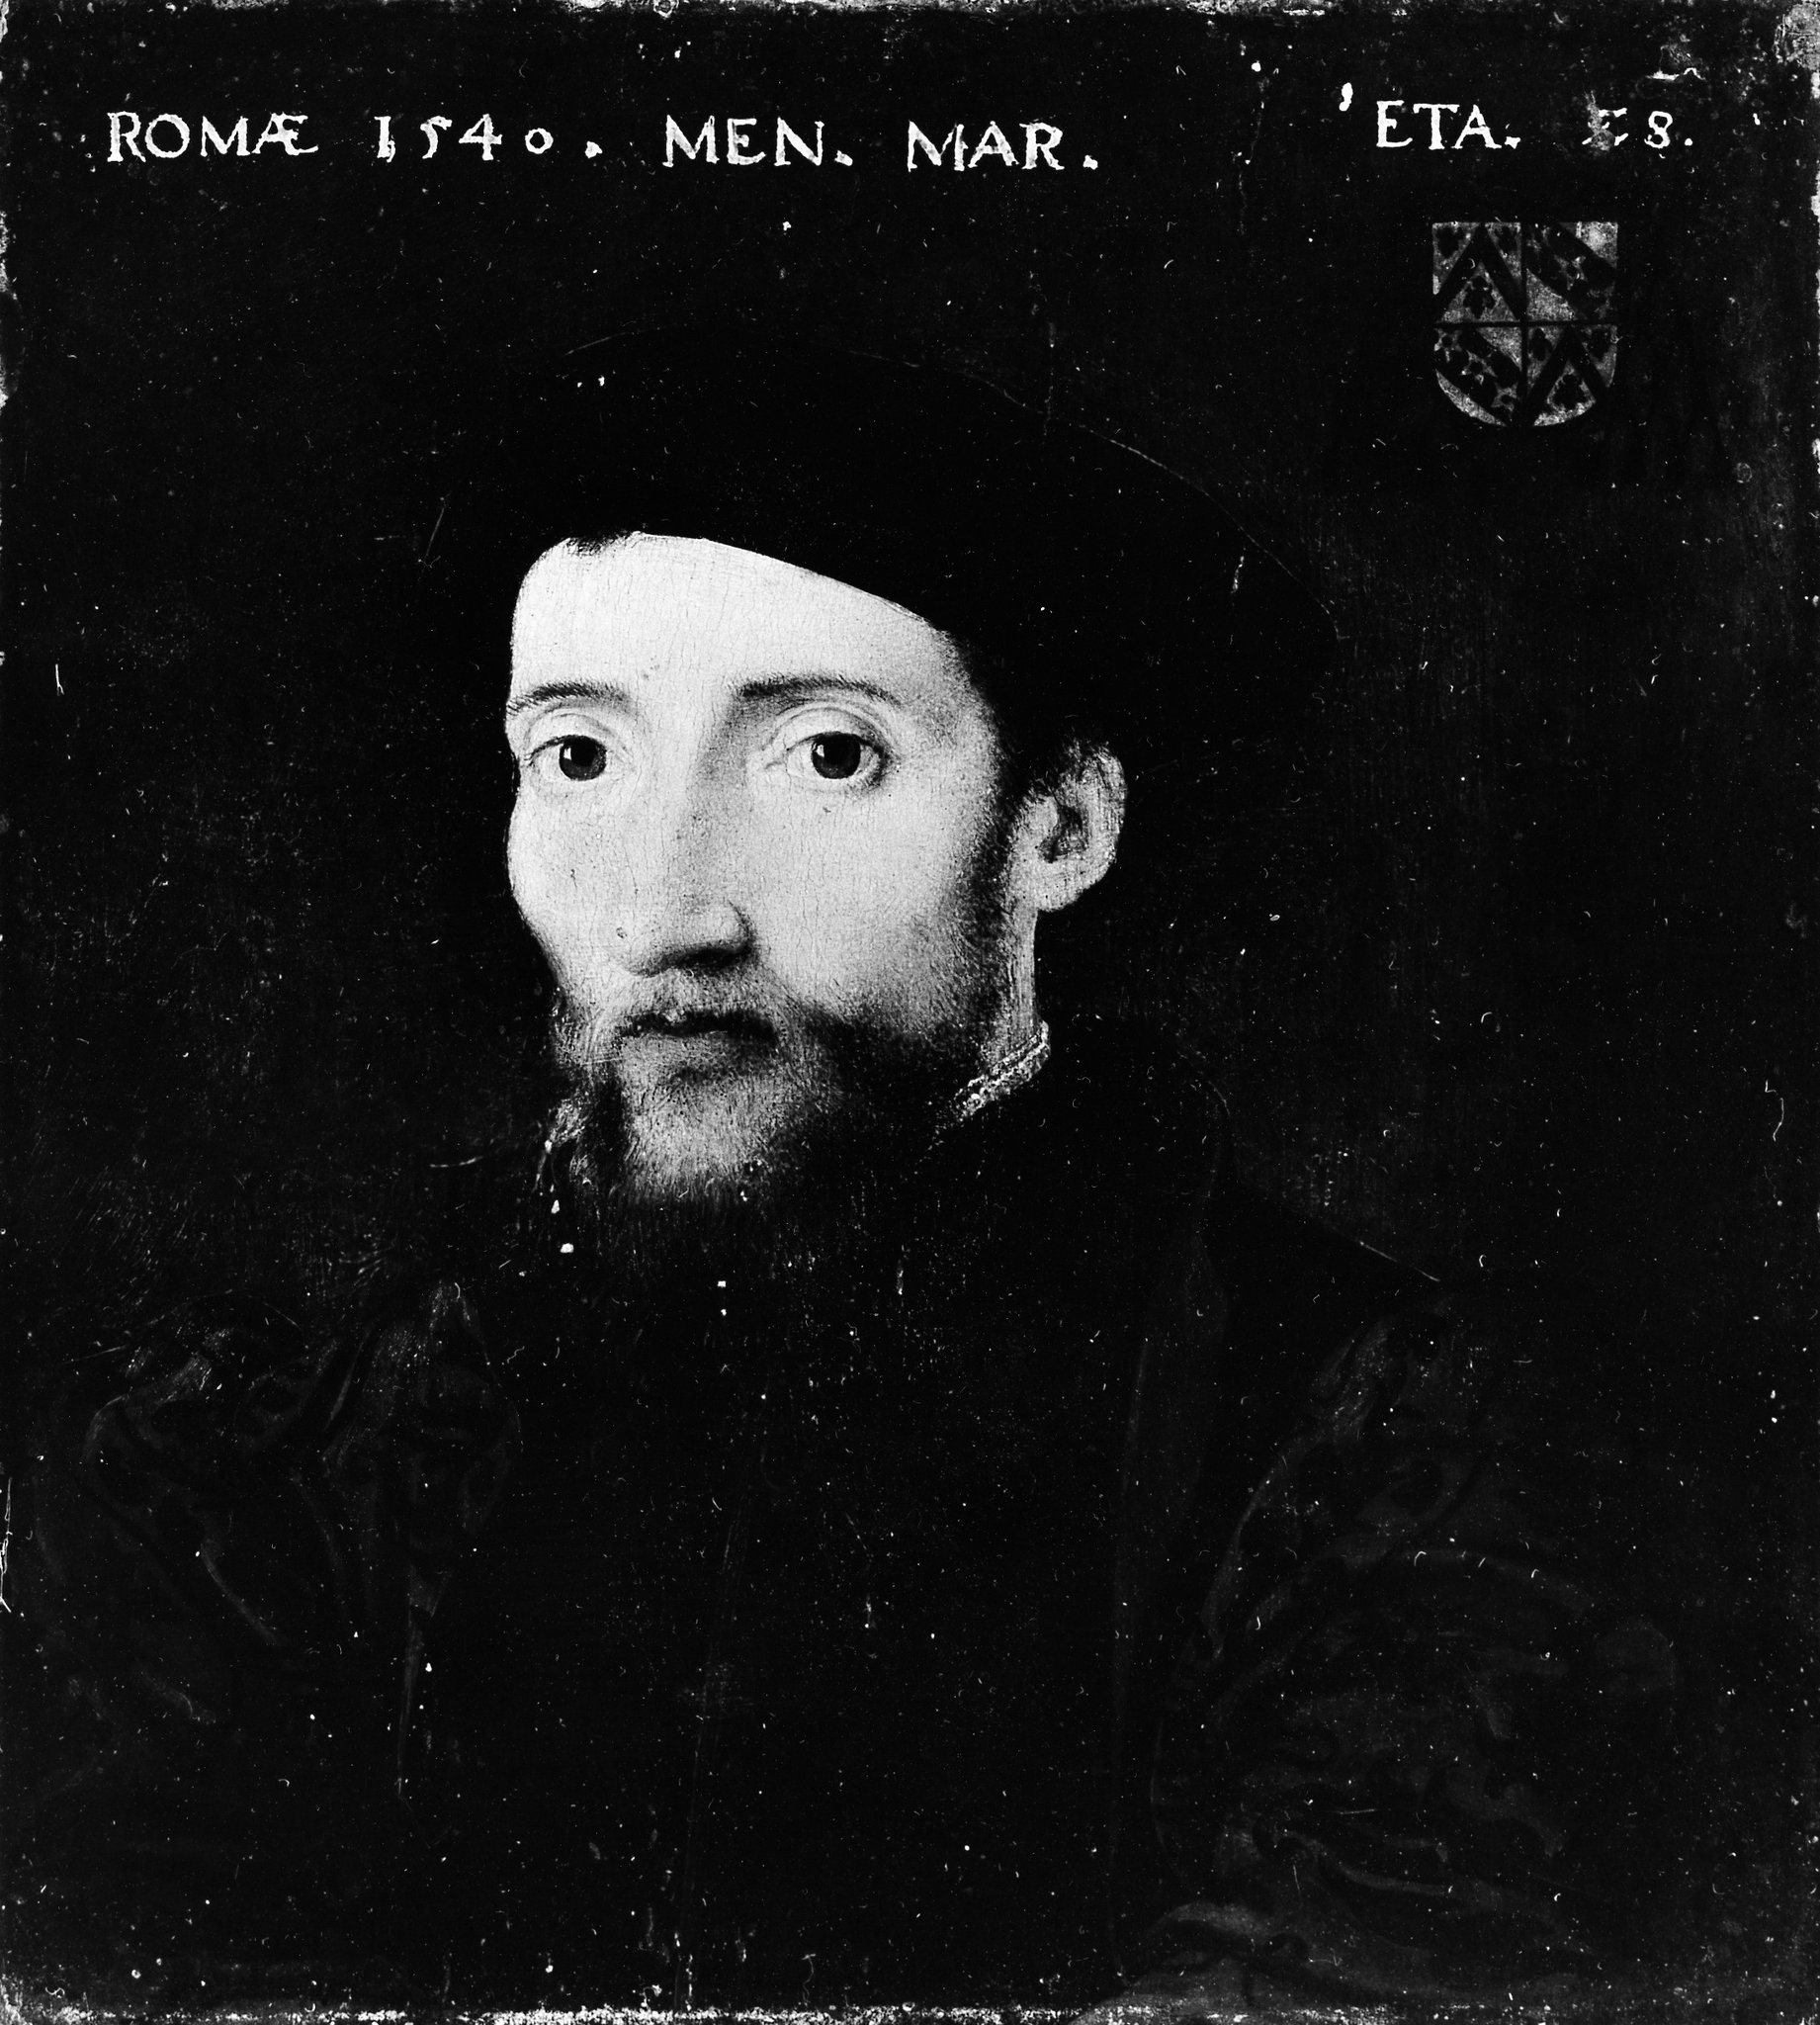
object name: painting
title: Portrait of a Member of the de Thou Family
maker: french painter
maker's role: artist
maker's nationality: french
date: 1540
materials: oil, wood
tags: men,portraits